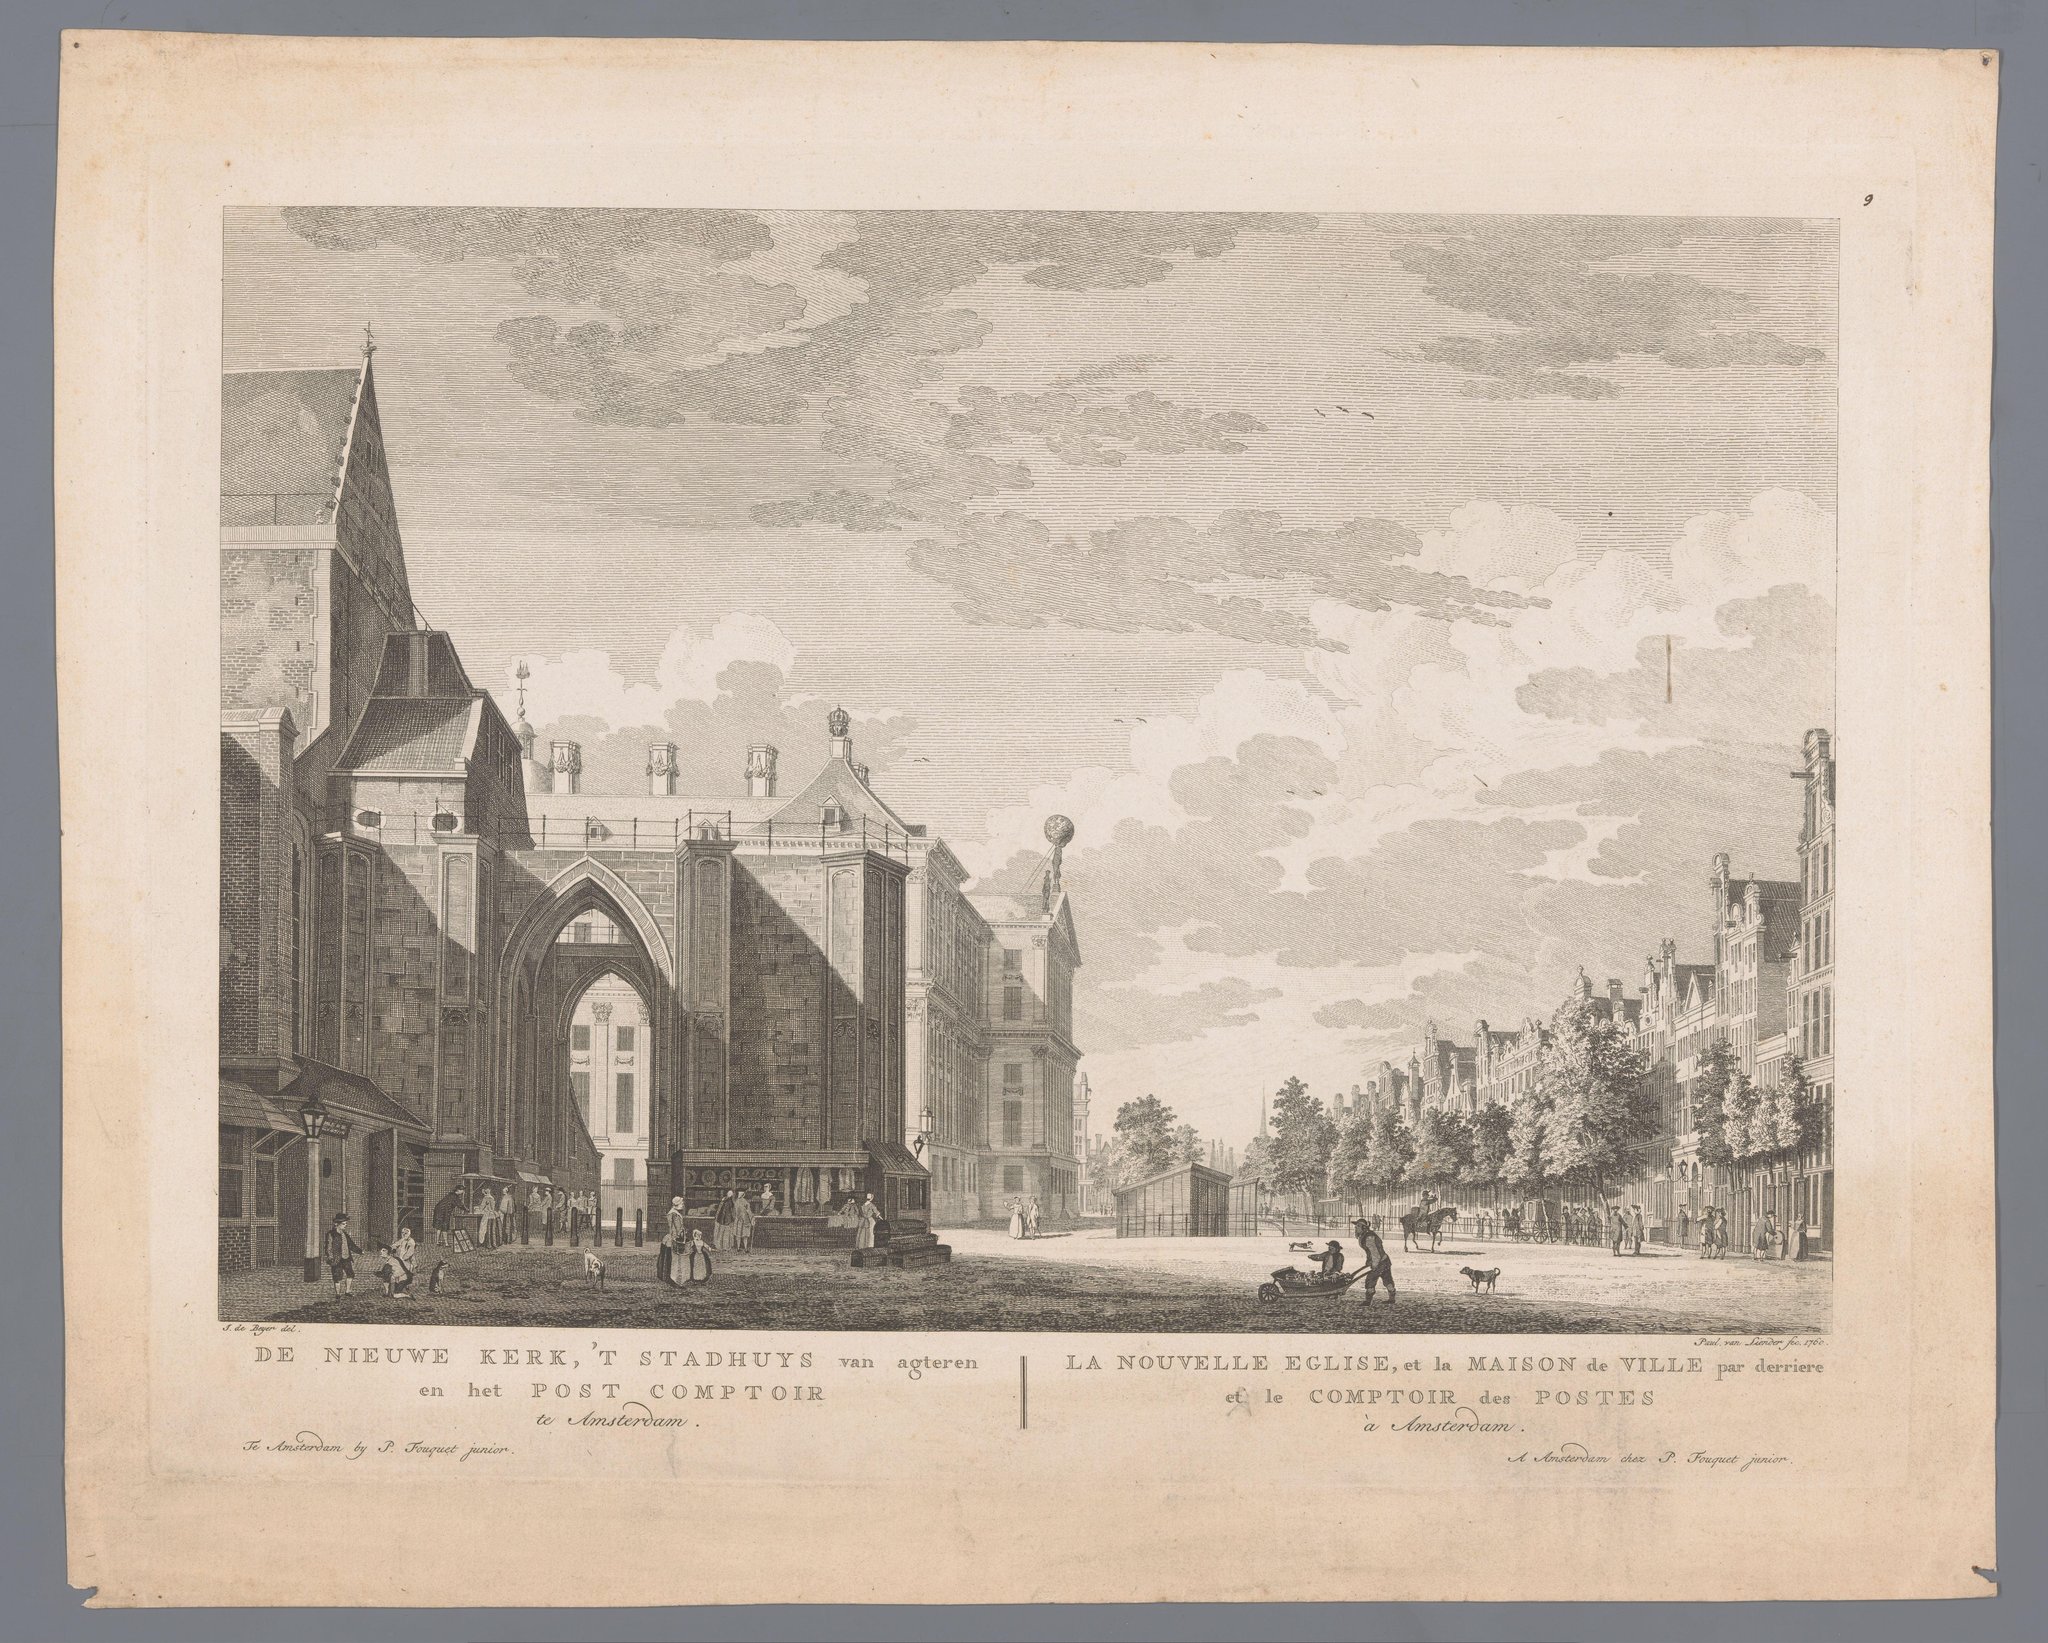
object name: print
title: Atlas van Fouquet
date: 1760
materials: paper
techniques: etching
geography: amsterdam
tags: post-office, church (exterior), townhall, square, place, circus, etc. (+ city(-scape) with figures, staffage)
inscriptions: inscription: ‘9’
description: Vanaf 1760 gaf Pierre Fouquet stadsgezichten van Amsterdam naar tekeningen van verschillende kunstenaars uit. Deze prenten werden aanvankelijk los verkocht. Later werden ze samengebonden verkocht in verschillende volgordes en aantallen in: (1). Afbeeldingen van de wyd-vermaarde koopstad Amsterdam benevens des zelvs voornaamste gebouwen en gezigten alle naar het leeven getekend / Receuil des edifices les plus considerables et des plus belles vues, de la fameuse ville d'Amsterdam, dessinées d'après nature. Amsterdam: Pierre Fouquet, 1778-1783. Deze 'uitgave' bestond waarschijnlijk alleen uit een titelblad en inhoudsopgave van de tot dusver 100 uitgegeven prenten, die de koper zelf aan zijn of haar reeds verzamelde prenten kon toevoegen. De hoeveelheid en volgorde van prenten verzameld onder deze titel verschilt dus sterk. (2). Nieuwe atlas, van de voornaamste gebouwen en gezigten der stad Amsterdam, met derzelver beknopte beschryvingen. 2 dln. Amsterdam: Daniël Jean Changuion en Petrus den Hengst [in opdracht van Pierre Fouquet], 1783. Ook werden er door verschillende uitgevers tussen 1788 (Amsterdam: Petrus Conradi) en 1805 (Amsterdam: Evert Maaskamp) heruitgaven gepubliceerd.